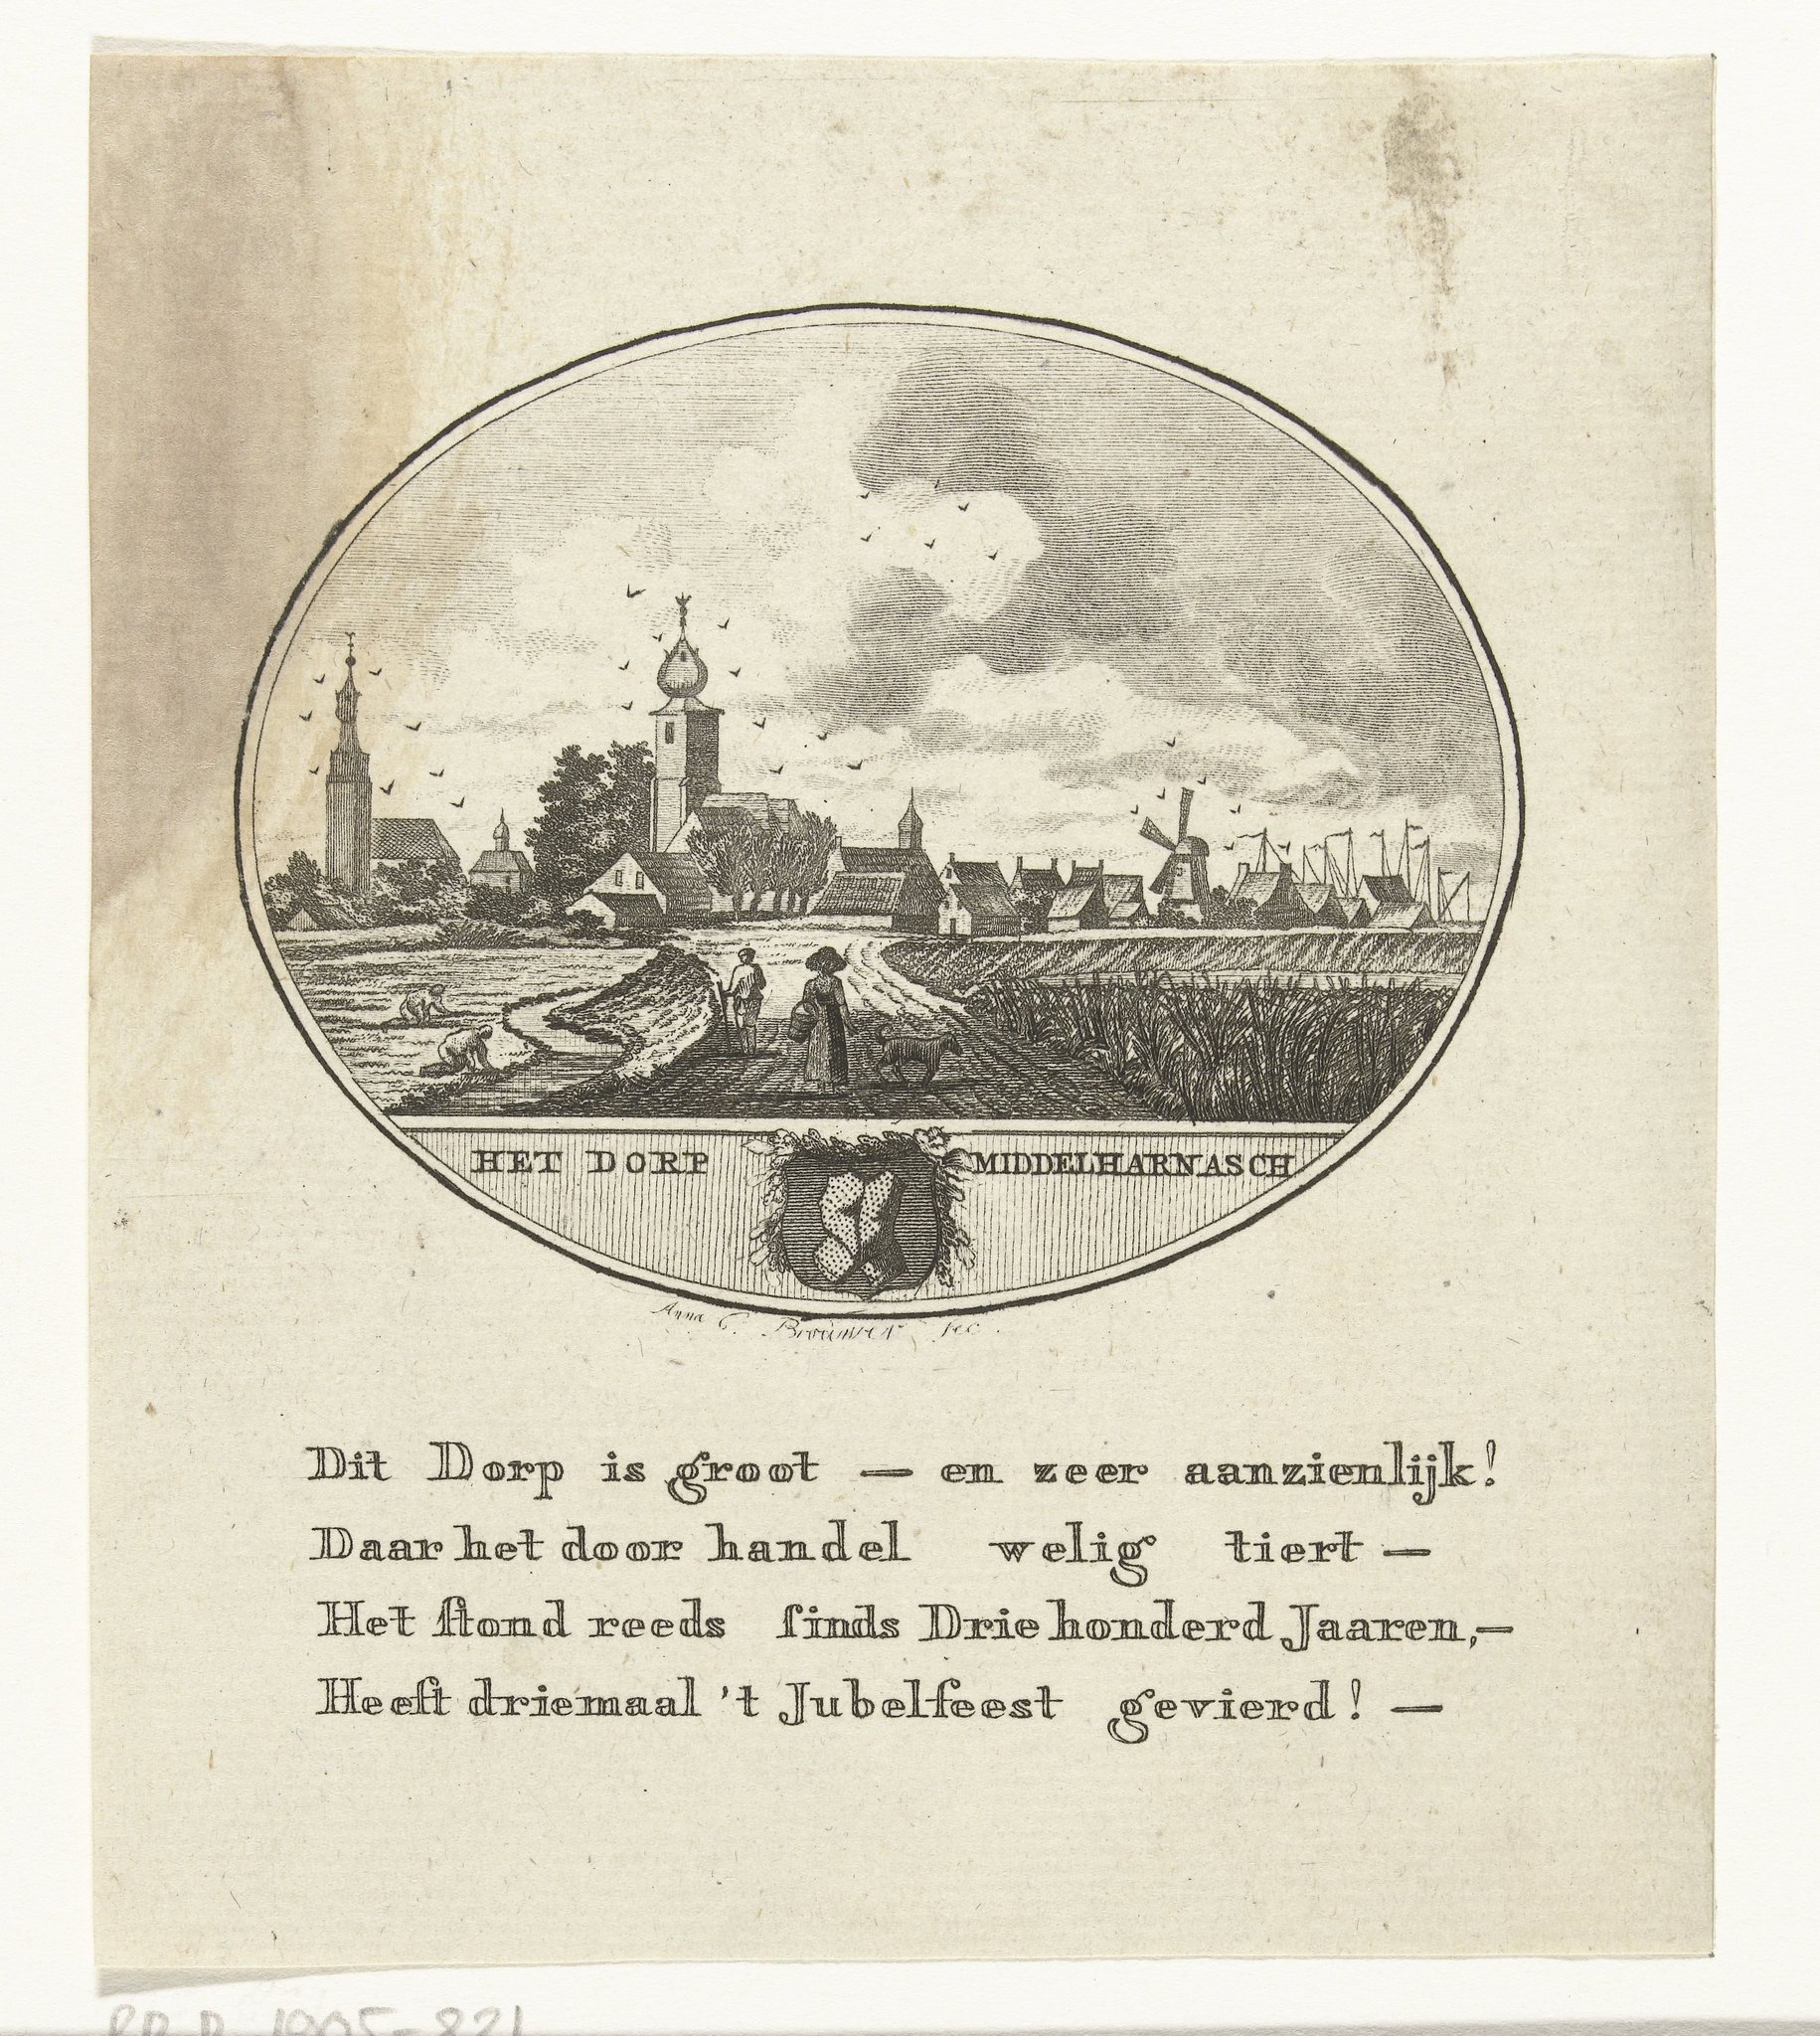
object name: book illustration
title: Het dorp Middelharnasch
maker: anna catharina brouwer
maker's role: print maker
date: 1796-1798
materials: paper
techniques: etching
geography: amsterdam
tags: city-view in general; 'veduta'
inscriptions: collector's mark: Lugt 2228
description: afkomstig uit: L. van Ollefen, De Nederlandsche stad- en dorp-beschrijver. Deel 6, Amsterdam: Hendrik Arend Banse, 1798.